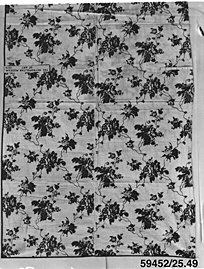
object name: piece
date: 1801-1833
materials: cotton